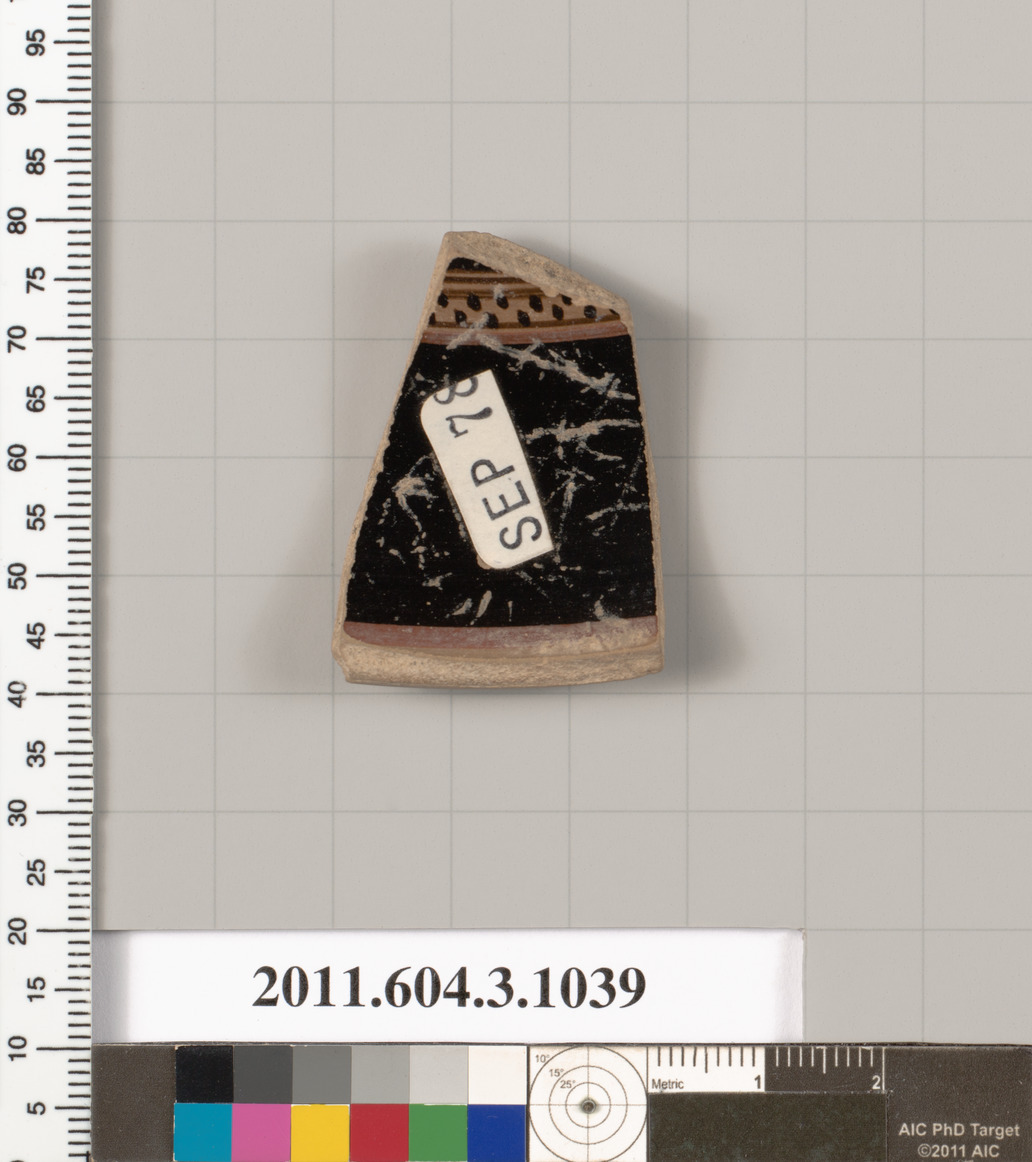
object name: undetermined shape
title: Terracotta fragment of an undetermined shape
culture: greek, attic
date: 534-501 BCE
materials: terracotta